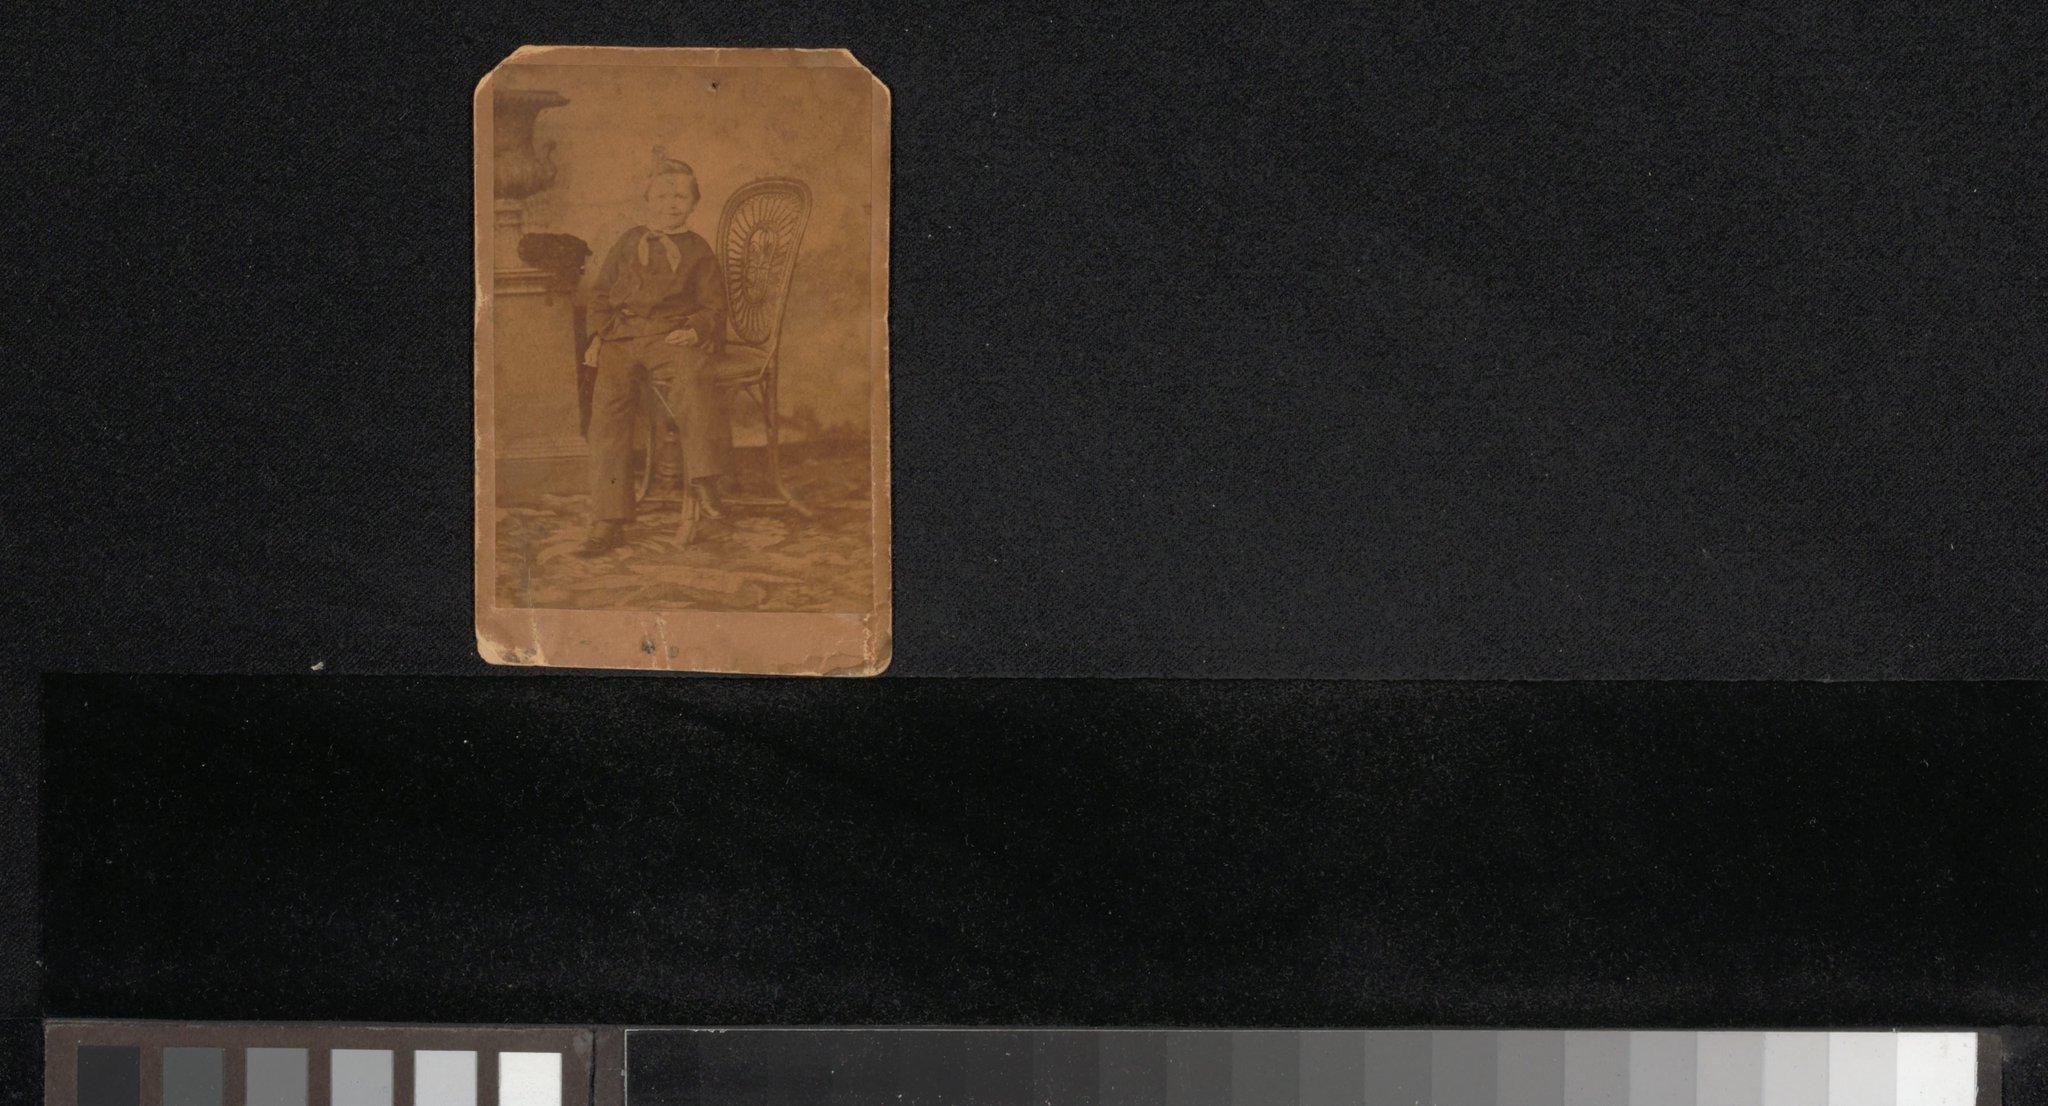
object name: photograph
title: Portret van Johann Friedrich Scheltema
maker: franz wilhelm deutmann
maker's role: fotograaf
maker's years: 1809-1895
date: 1860-1870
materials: cardboard, photographic support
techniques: albumen print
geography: amsterdam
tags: london, historical persons (portraits and scenes from the life)